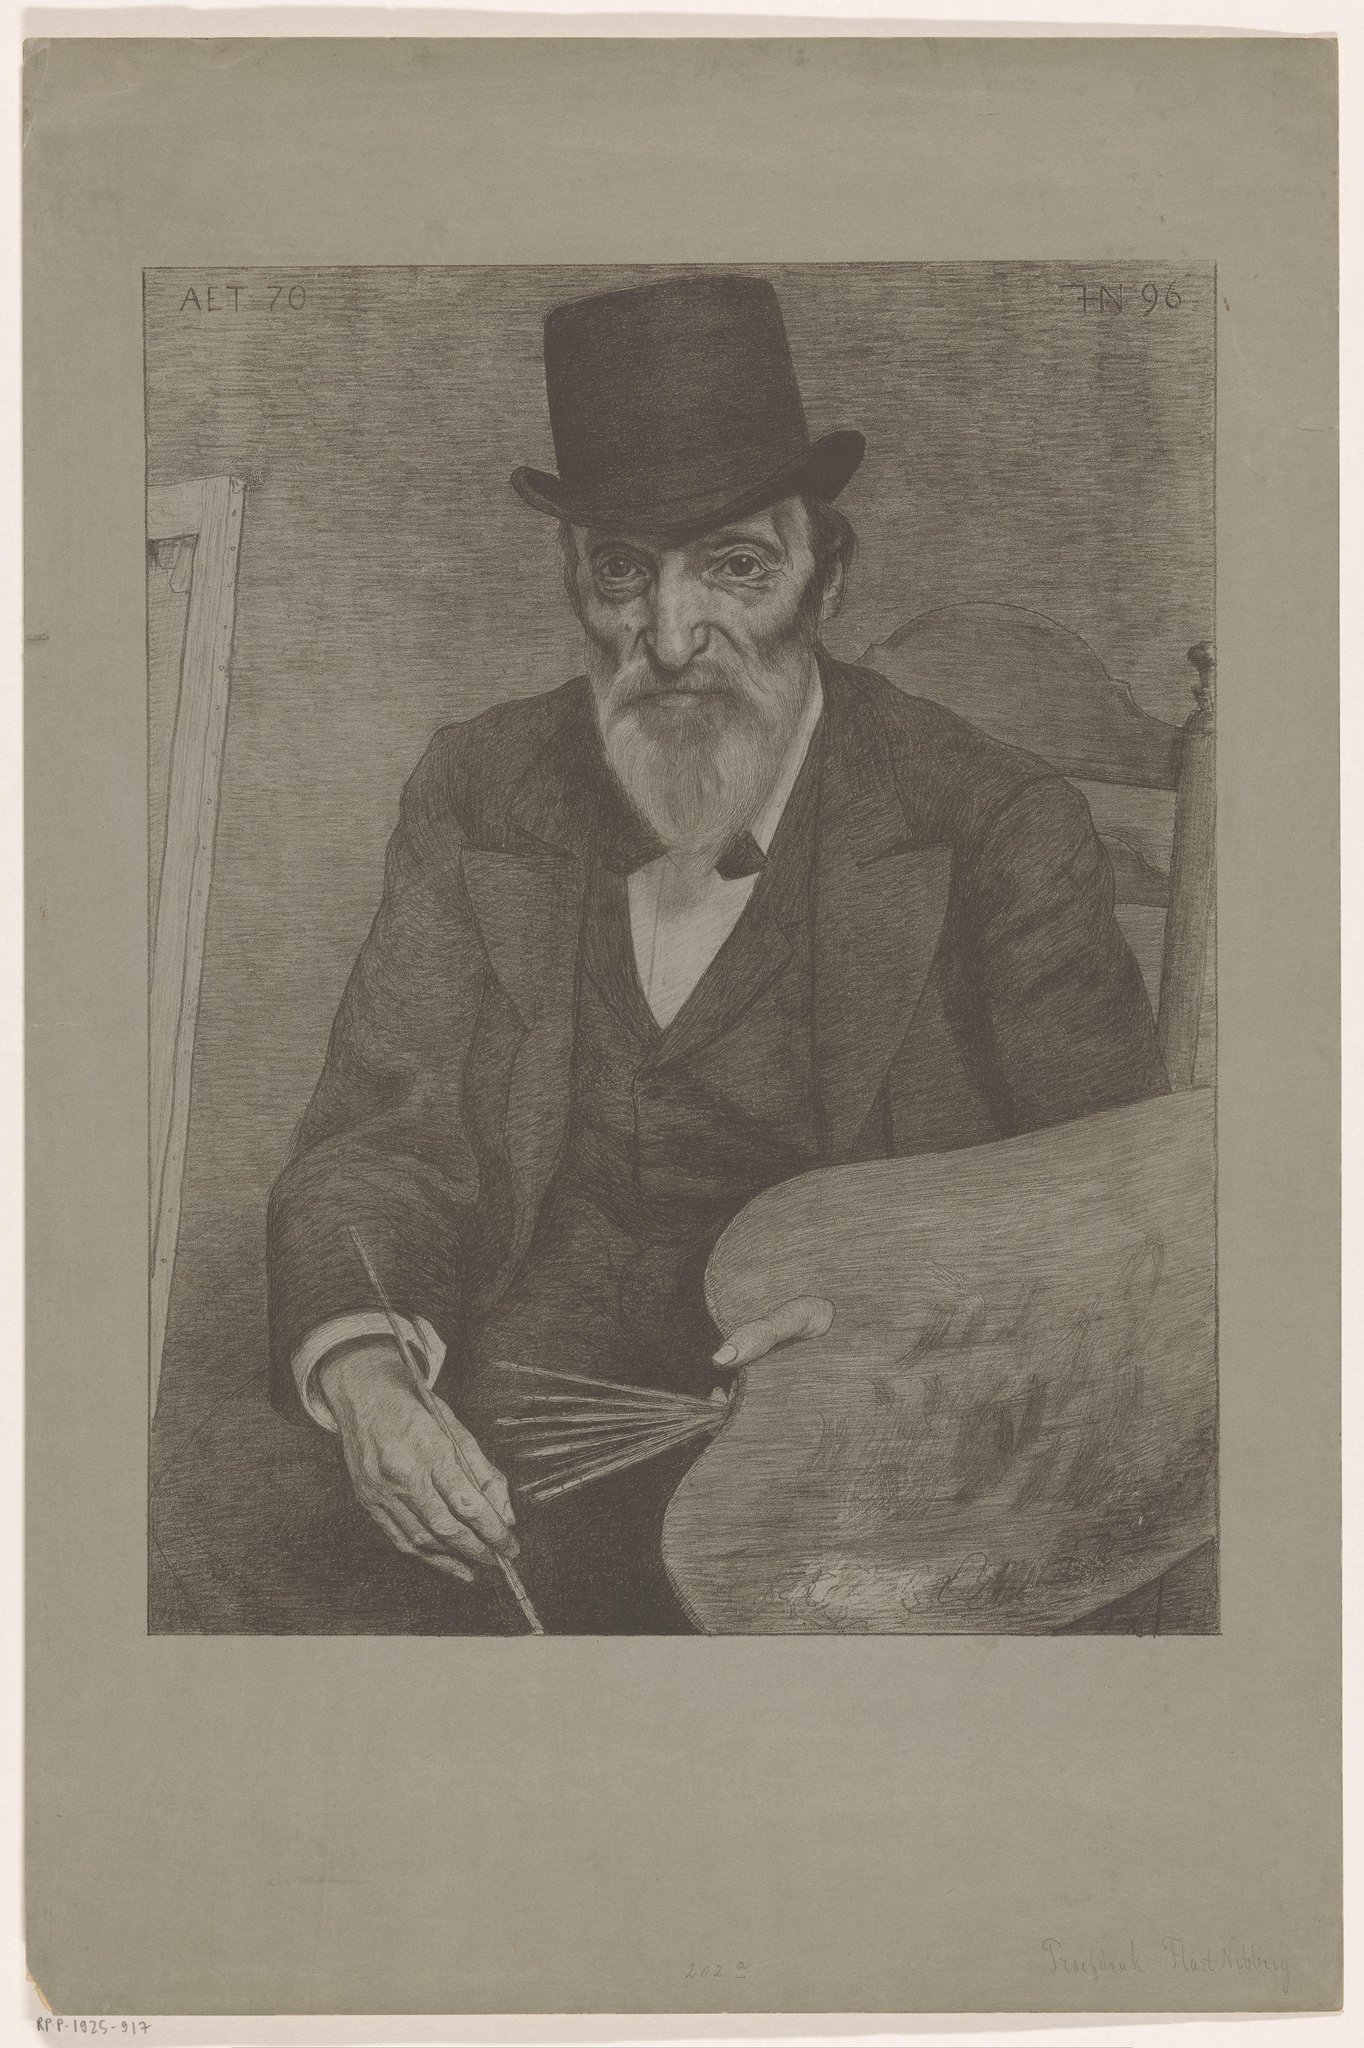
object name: print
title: Portret van Hendrik Valkenburg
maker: ferdinand hart nibbrig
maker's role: draughtsman, painter, print maker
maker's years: 1866-1915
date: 1896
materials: paper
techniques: lithograph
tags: amsterdam, painter, draughtsman, portrait, self-portrait of painter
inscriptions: collector's mark: Lugt 2228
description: Een portret van kunstenaar Hendrik Valkenburg op zeventigjarige leeftijd, met een schildersezel in zijn hand.